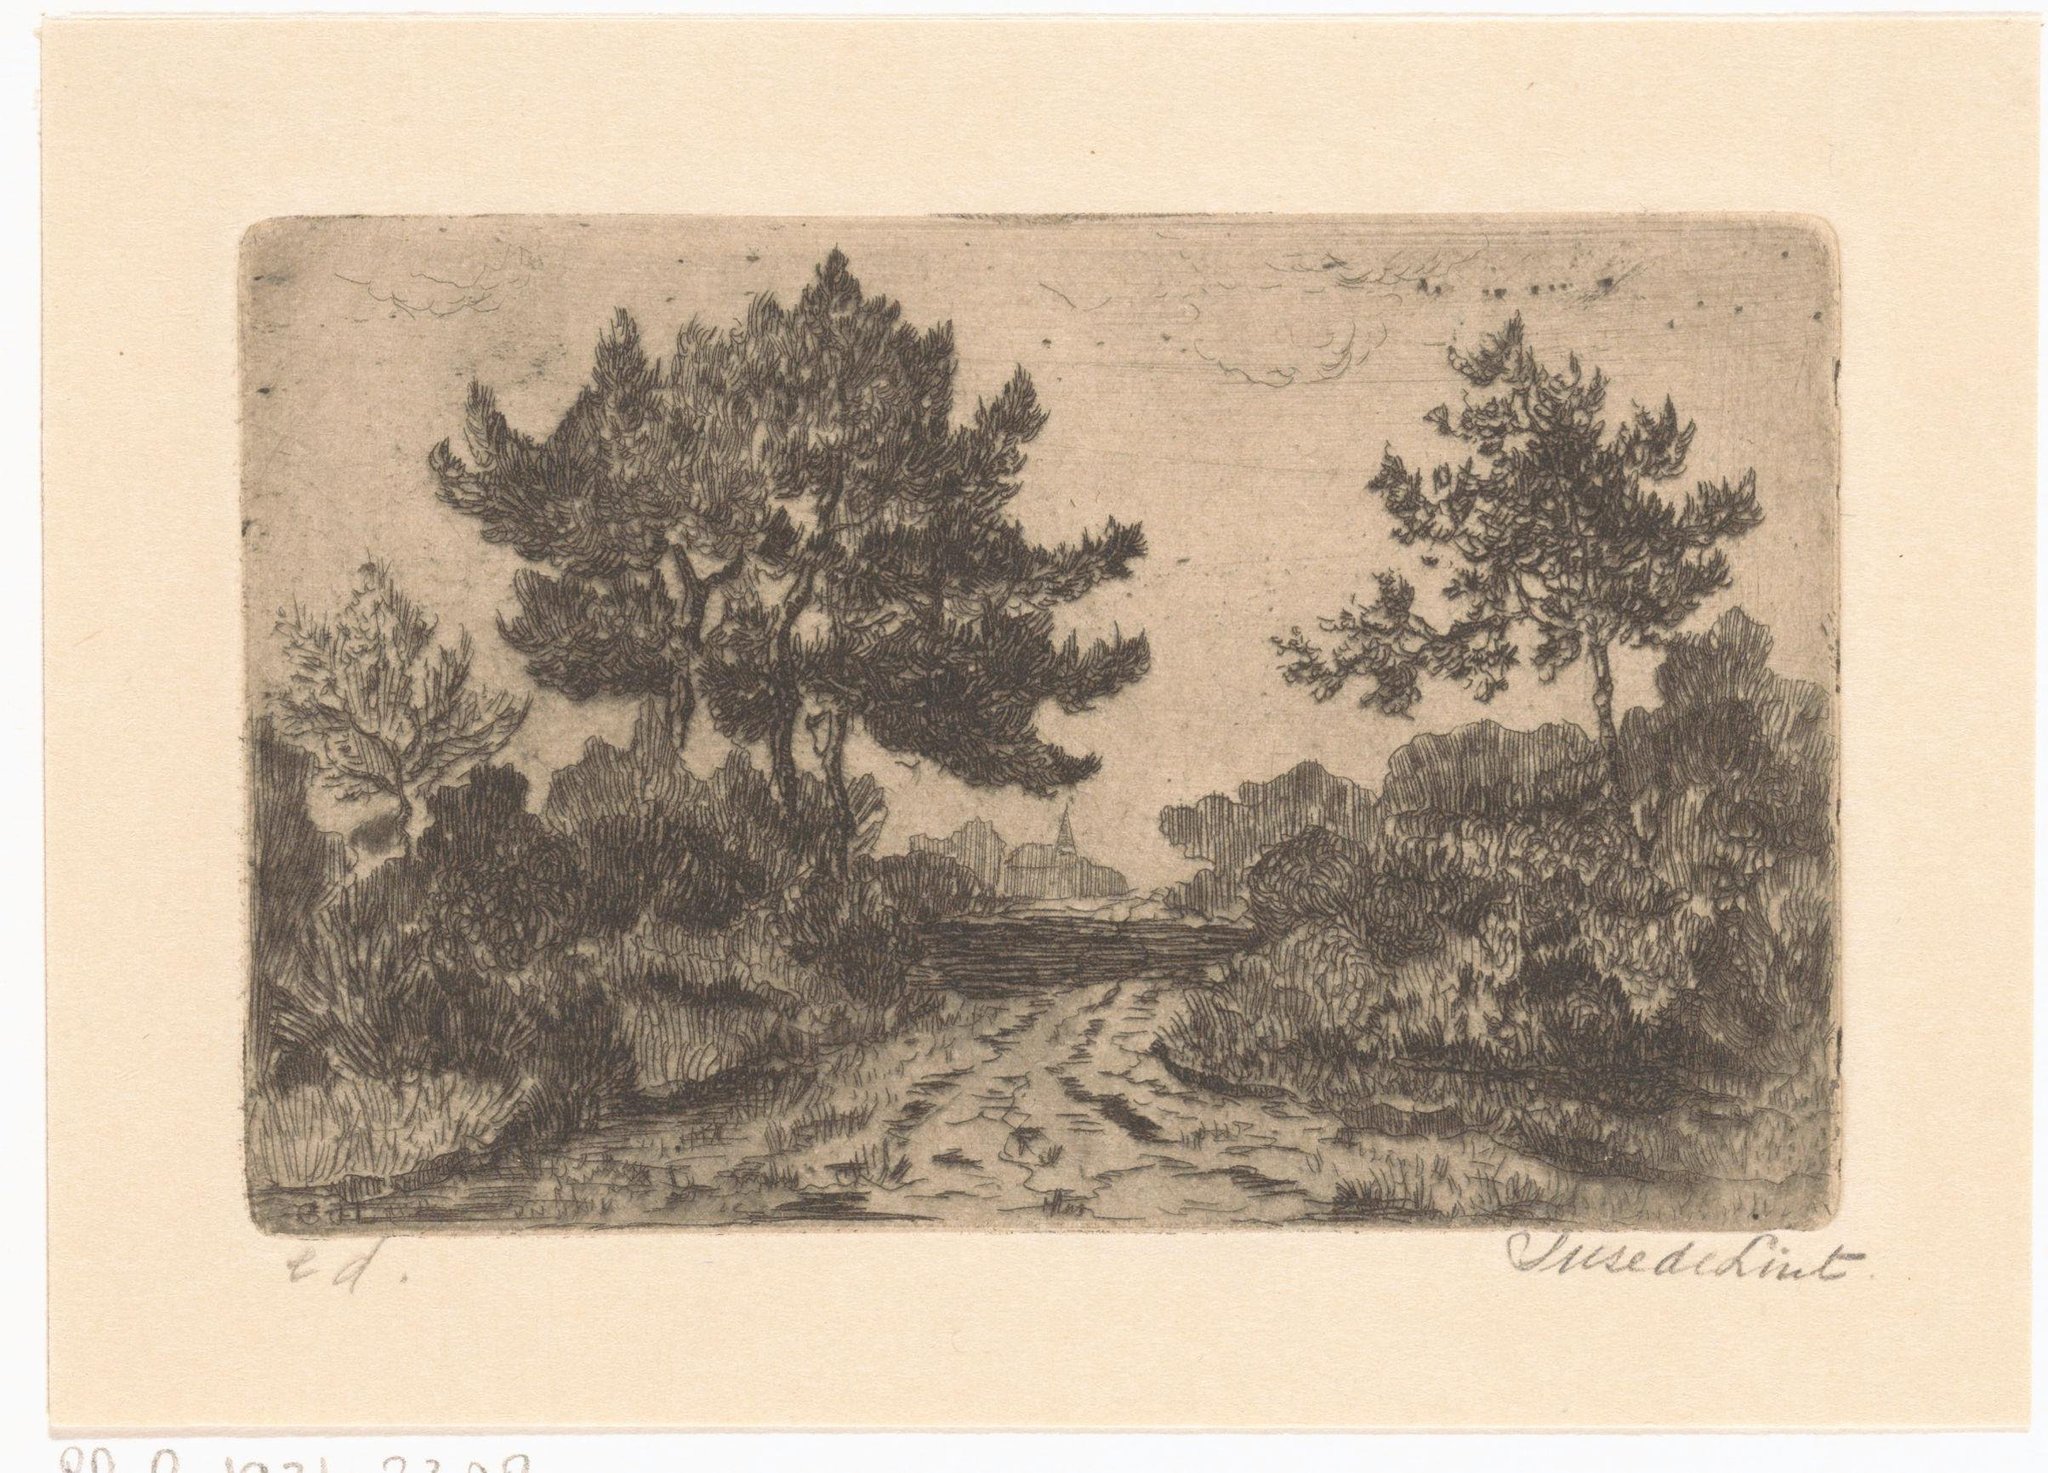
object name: print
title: Landweg met struikgewas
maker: suze de lint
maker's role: print maker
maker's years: 1878-1953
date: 1888-1931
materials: paper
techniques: etching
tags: shrubs, road, path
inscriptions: collector's mark: Lugt 2228